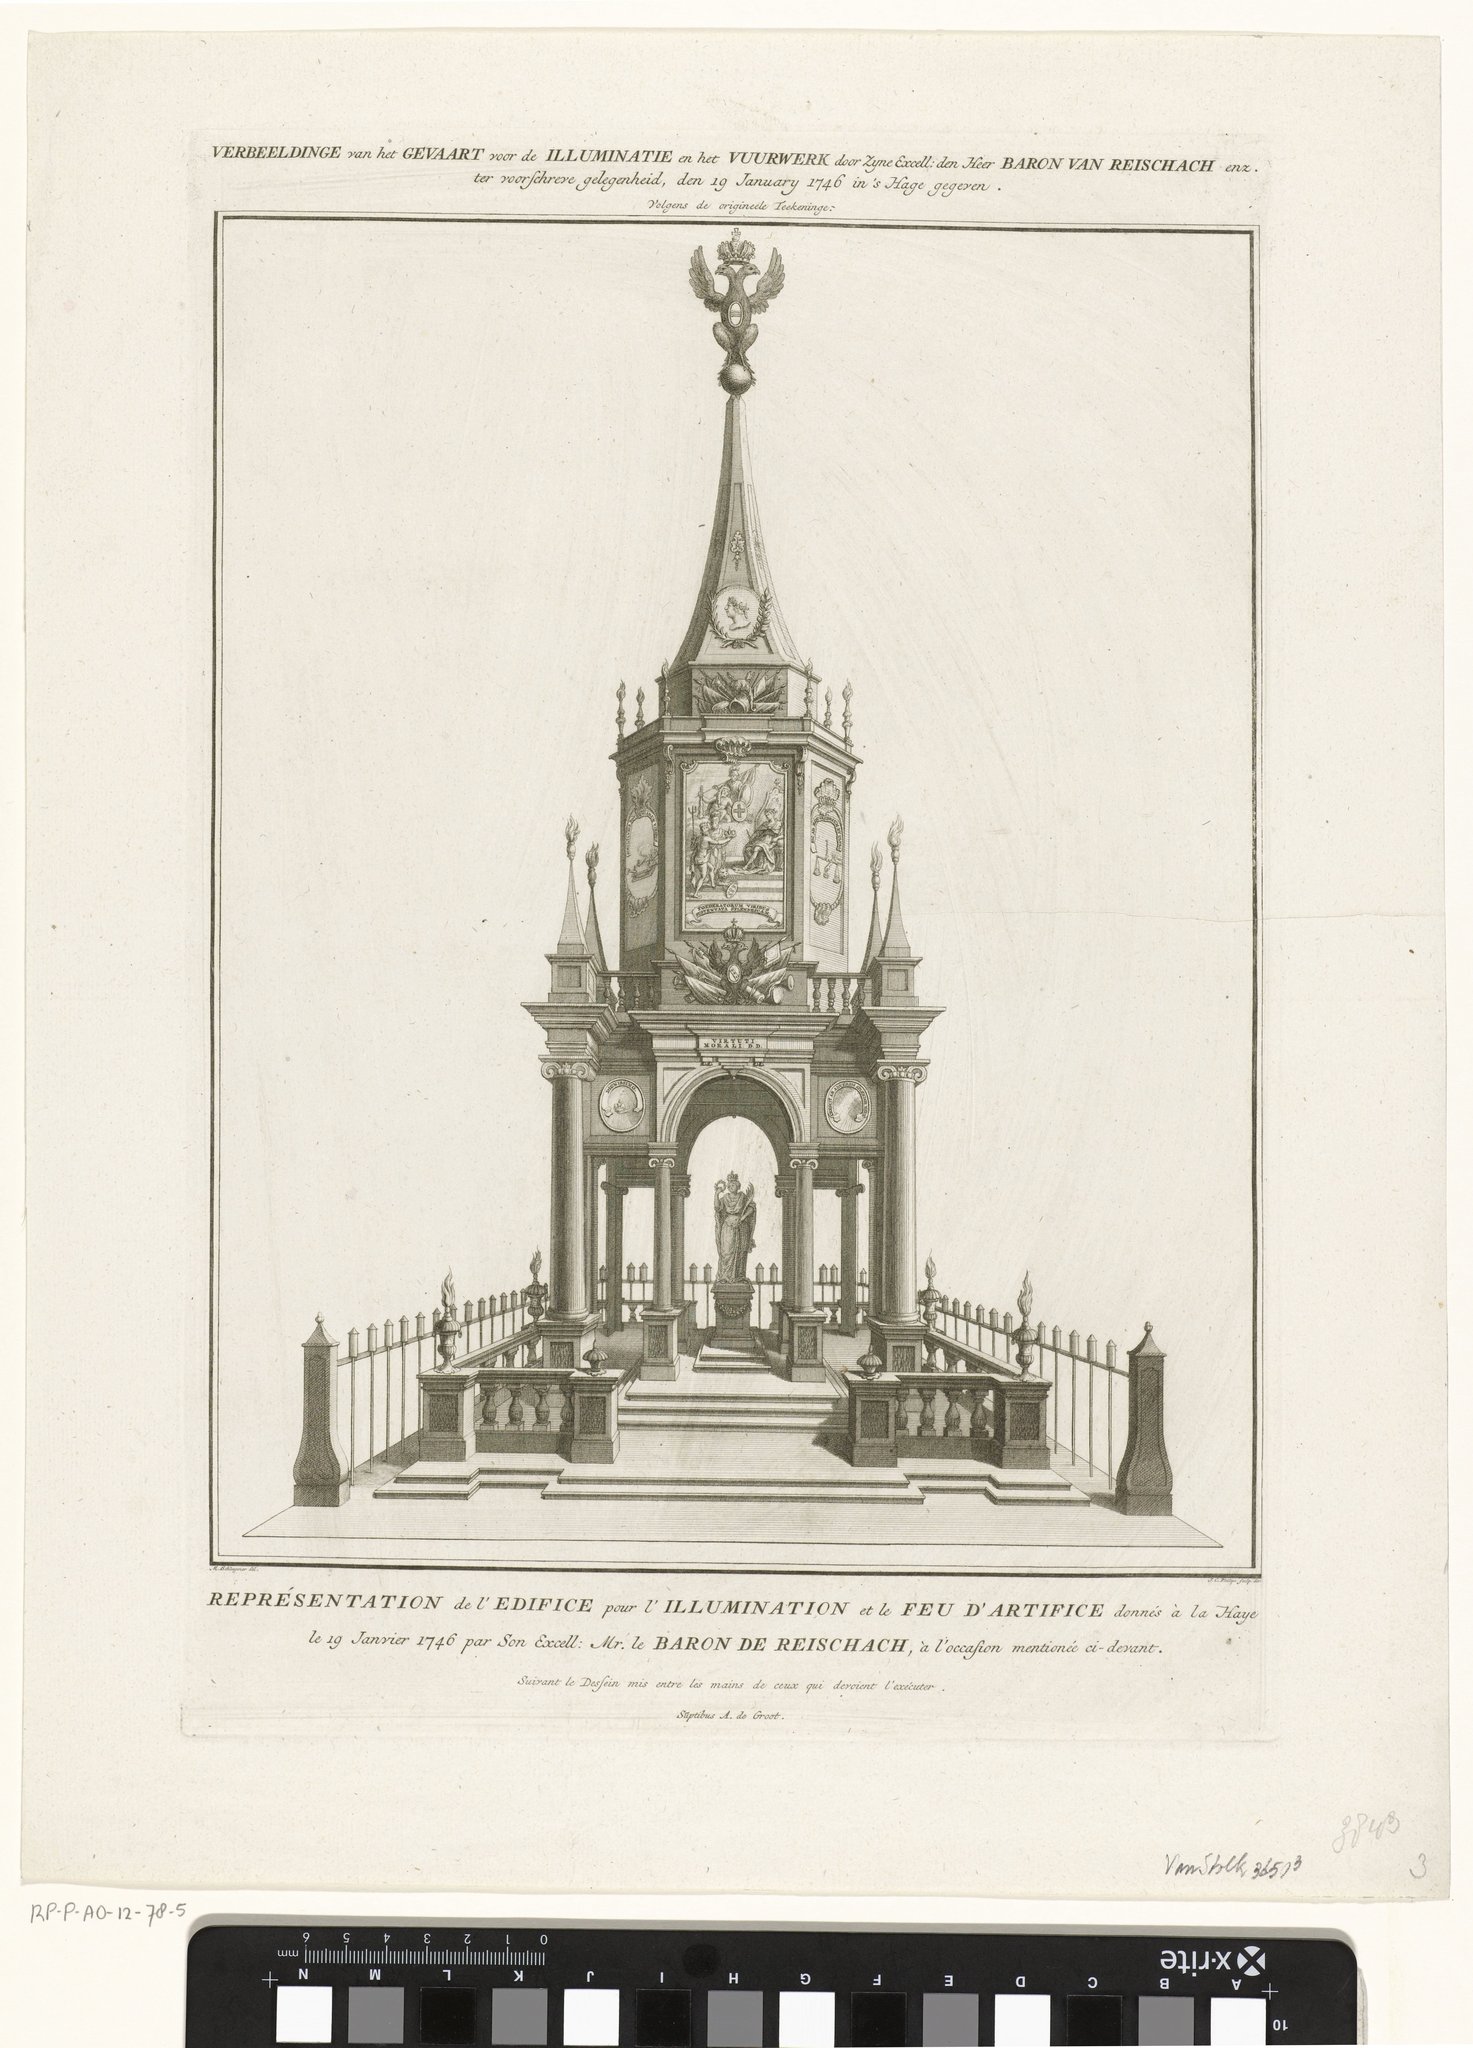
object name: print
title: Verbeeldinge van het gevaart voor de illuminatie en het vuurwerk door zyne excell: den heer baron van Reischach enz. ter voorschreve gelegenheid, den 19 january 1746 in 's Hage gegeven / Représentation de l'edifice pour l'illumination et le feu d'artifice donnés à La Haye le 19 janvier 1746 par son excell: mr. le baron de Reischach, à l'occasion mentionée ci-devant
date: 1746-1747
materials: paper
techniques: engraving, etching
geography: the hague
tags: frans i stefan (duits keizer), public festivities (+ illumination, fire-works ~ festive activities), coronation of a ruler, bonfire, fire-works (+ illumination, fire-works ~ festive activities)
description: Het bouwwerk (tempel of gevaarte) voor het vuurwerk afgestoken op 19 januari 1746 op de Hofvijver te Den Haag in opdracht van de Duitse minister en afgezant baron van Reischach ter gelegenheid van de kroning van Frans I Stefan tot keizer op 4-6 oktober 1745.